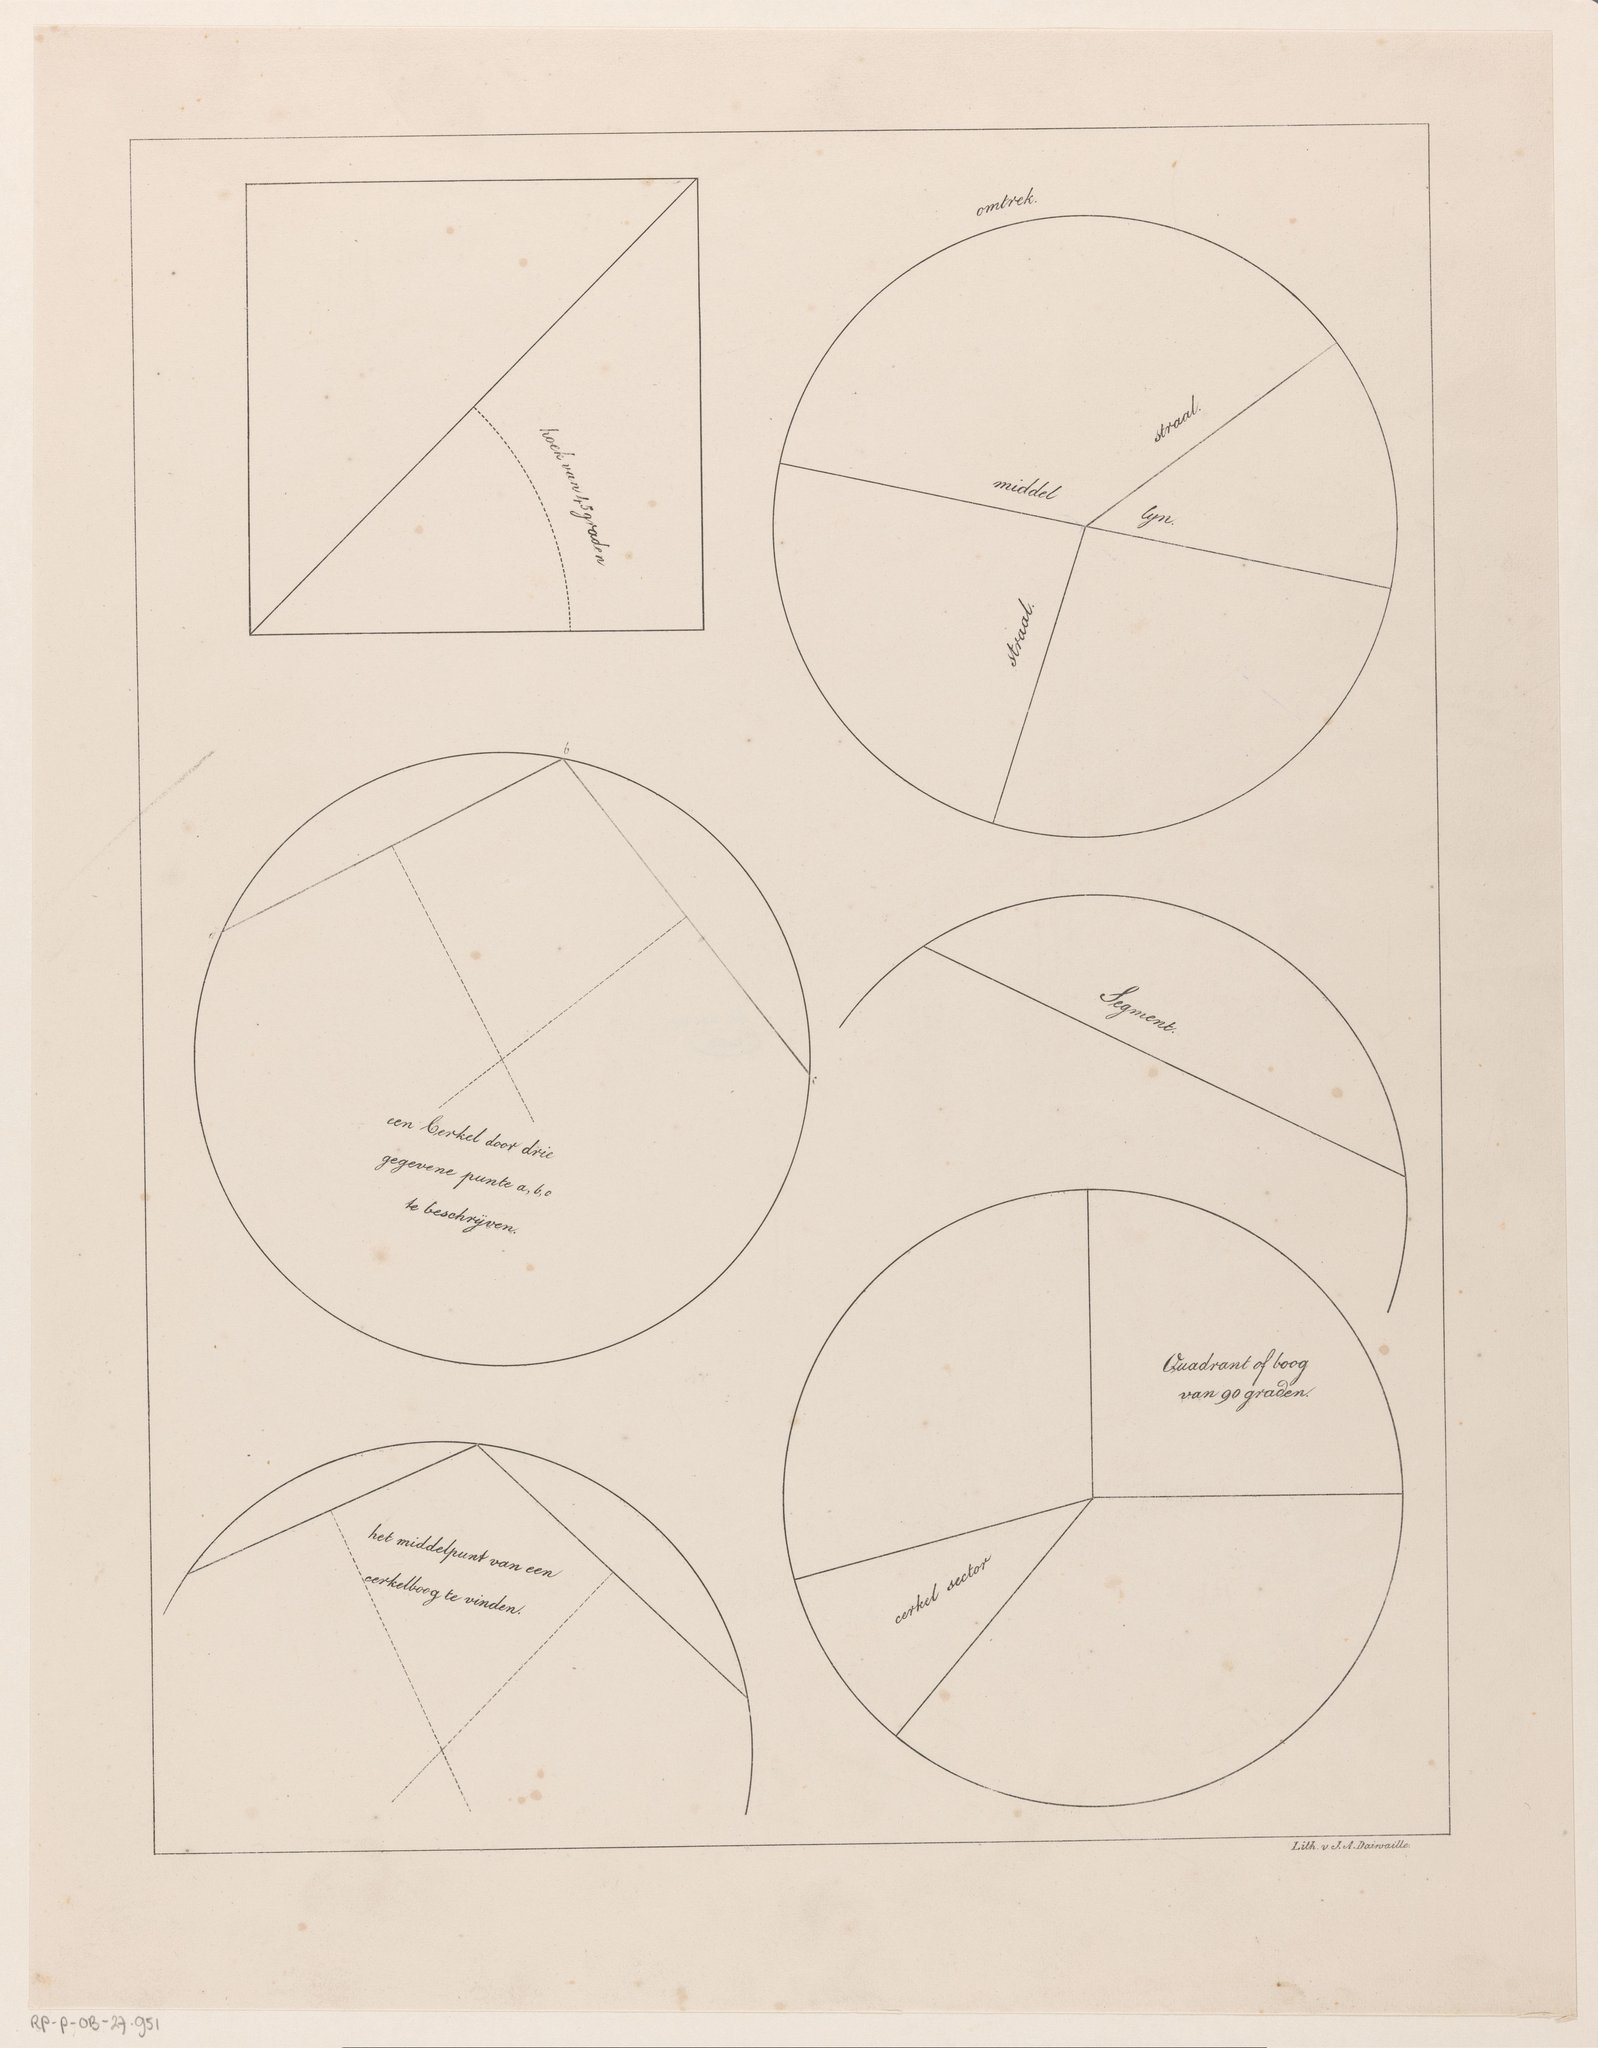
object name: print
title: Circels verdeeld door lijnen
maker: jean augustin daiwaille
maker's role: draughtsman, print maker, printer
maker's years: 1786-1850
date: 1820-1833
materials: paper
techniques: lithograph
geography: amsterdam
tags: segment of circle, quadrature of the circle, circle (~ planimetry, geometry)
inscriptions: collector's mark: Lugt 2228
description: In de circels staan begrippen zoals: 'straal' en 'Quadrant of boog van 90 graden'.